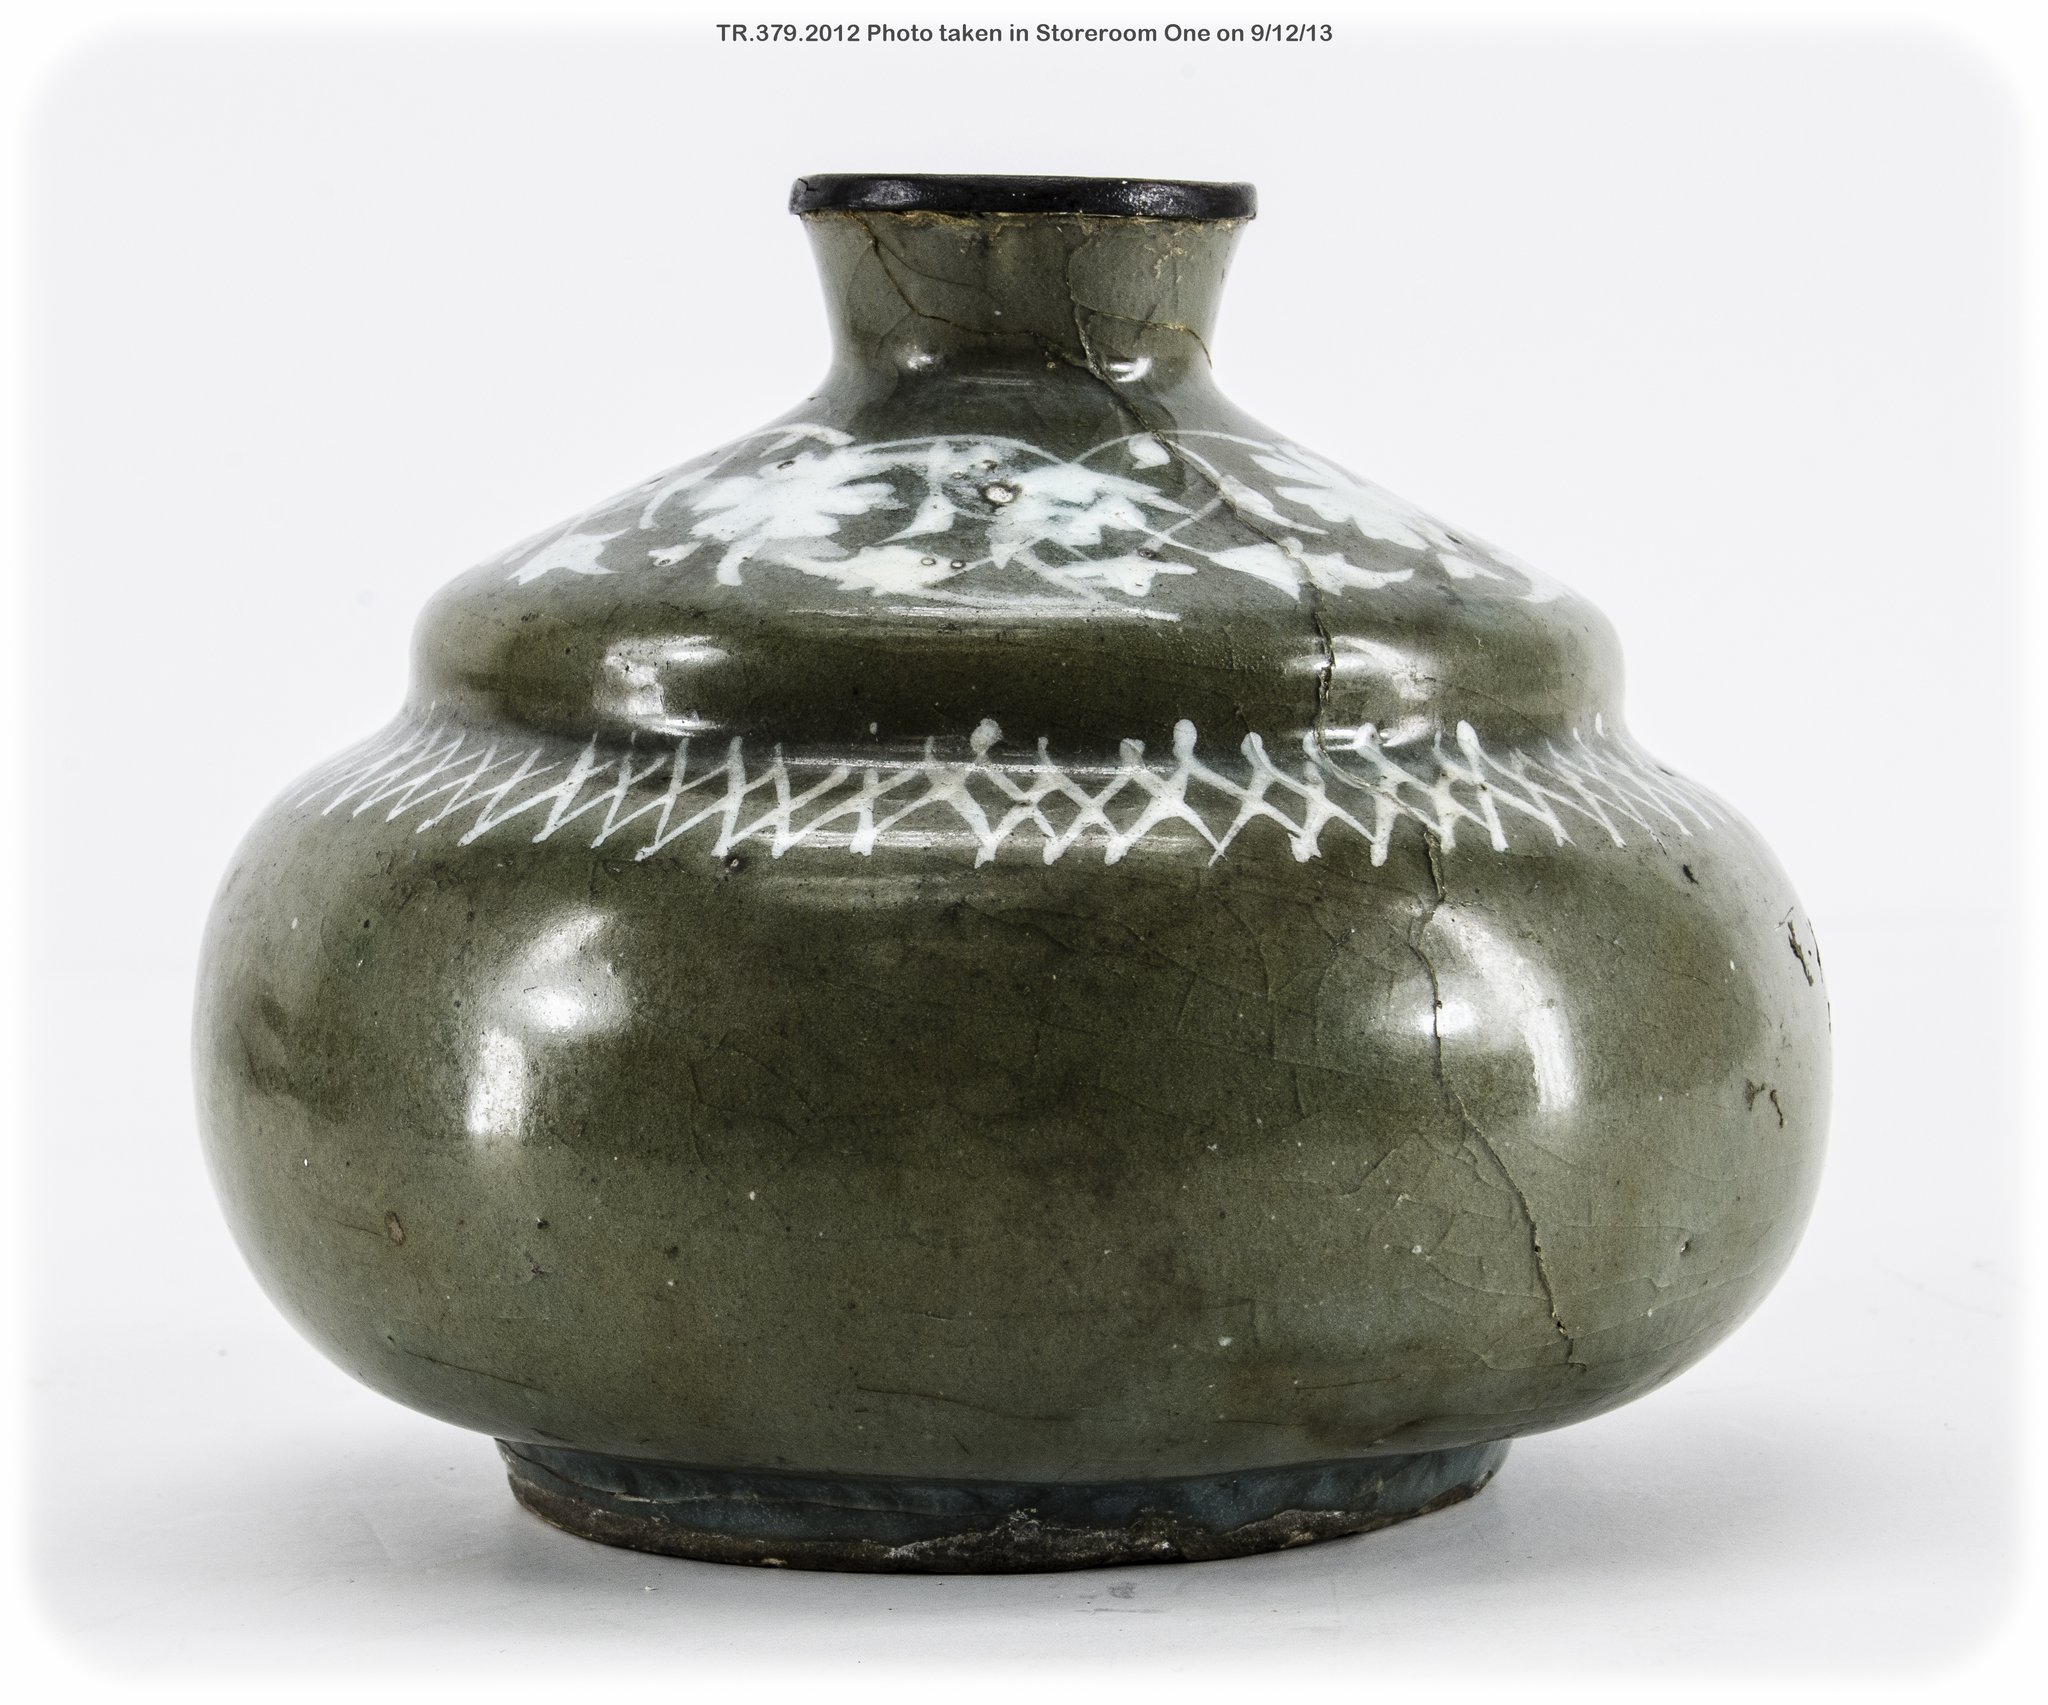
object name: vase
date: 1651-1700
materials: stonepaste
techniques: glazing, painting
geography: iran